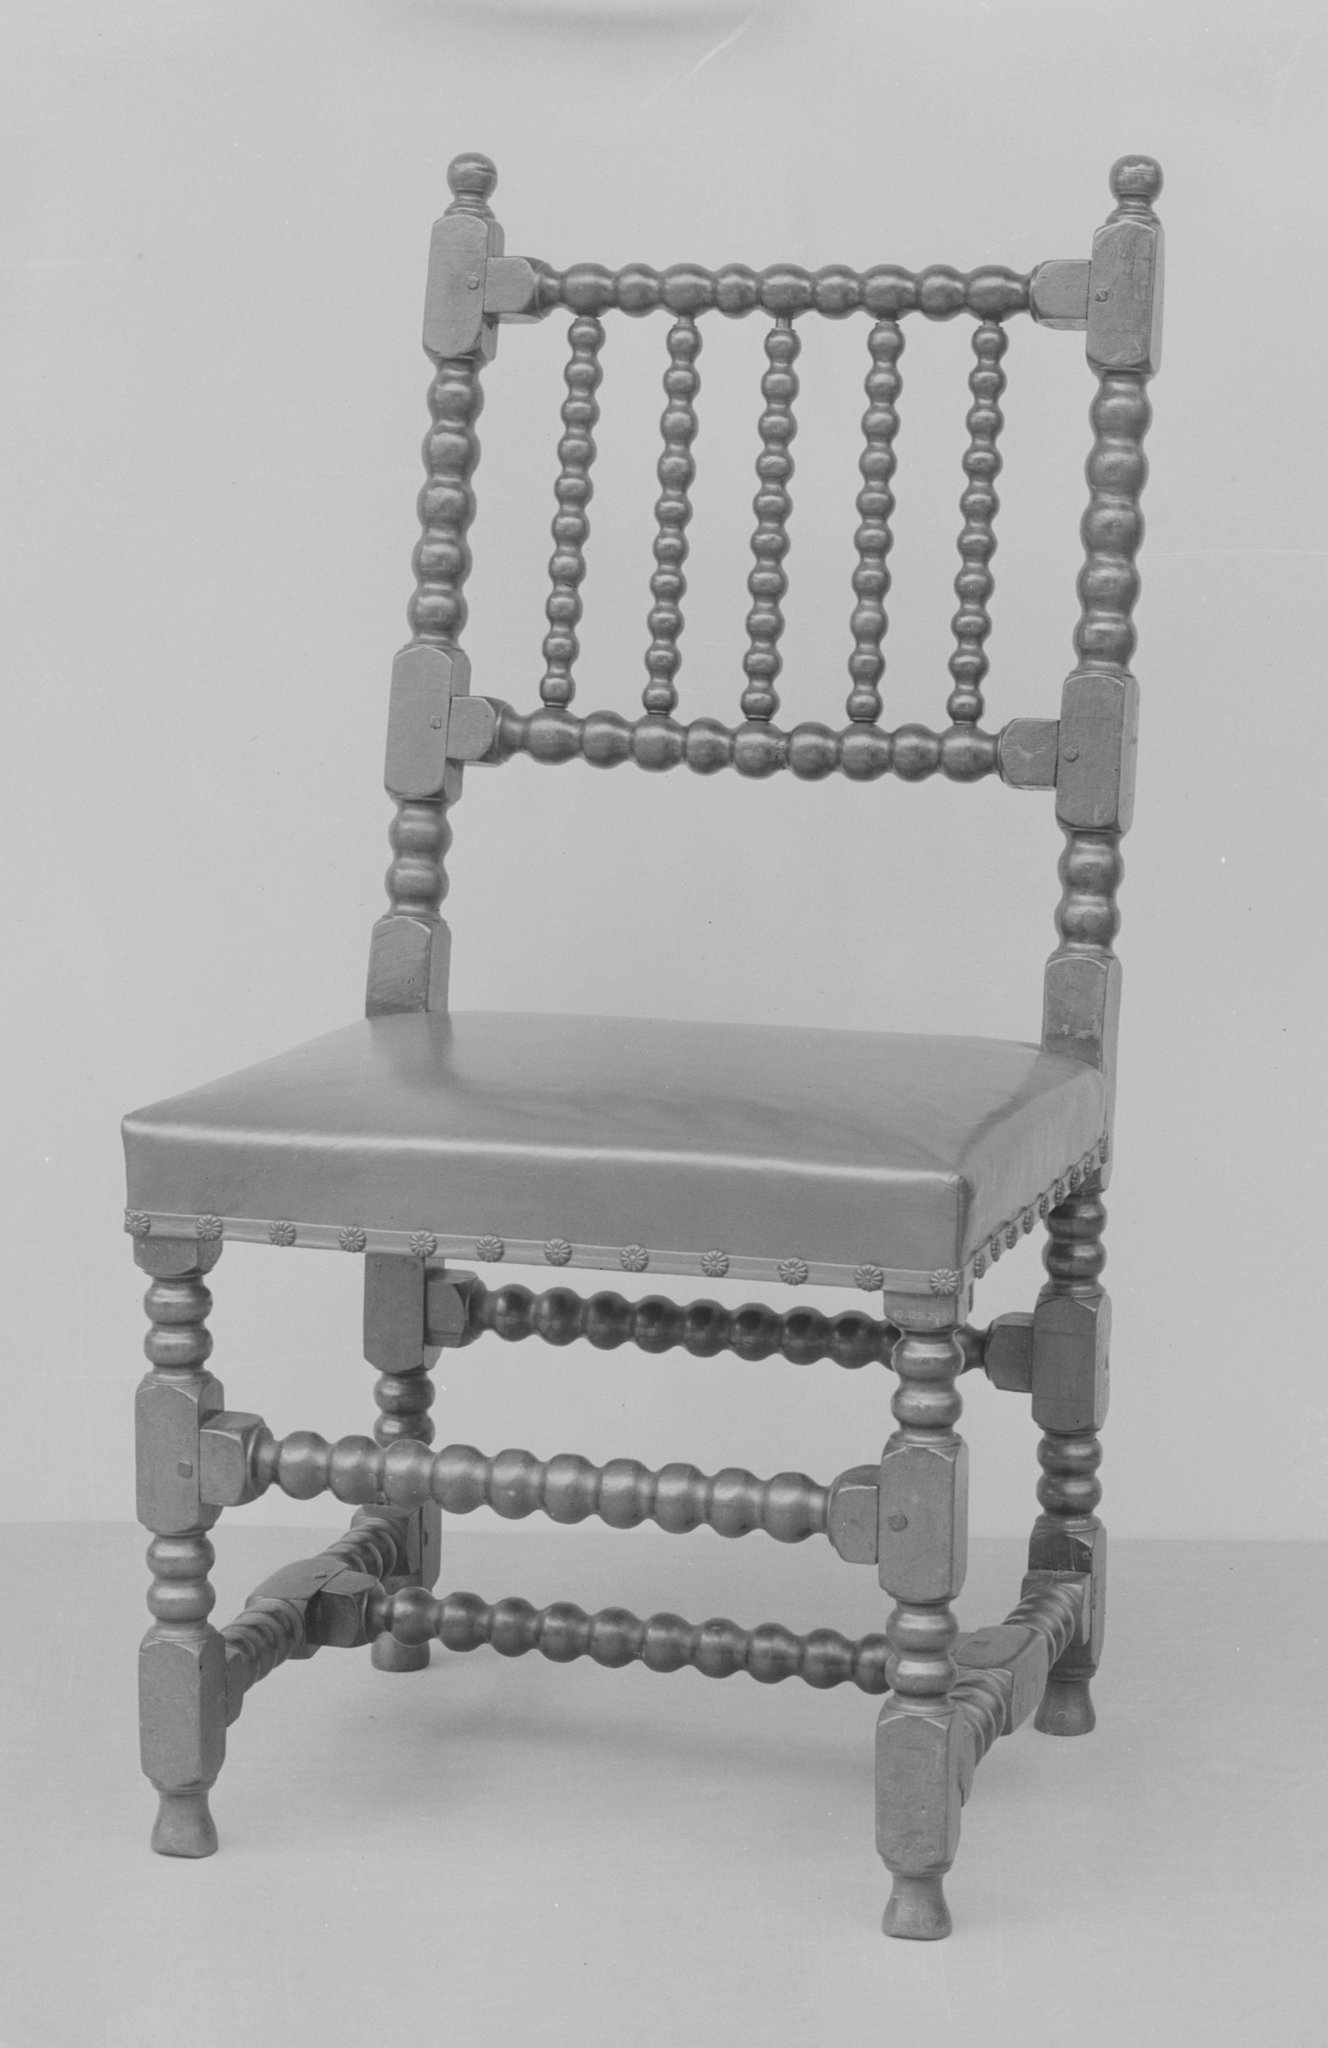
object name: side chair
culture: american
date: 1675-1700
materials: wood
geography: united states